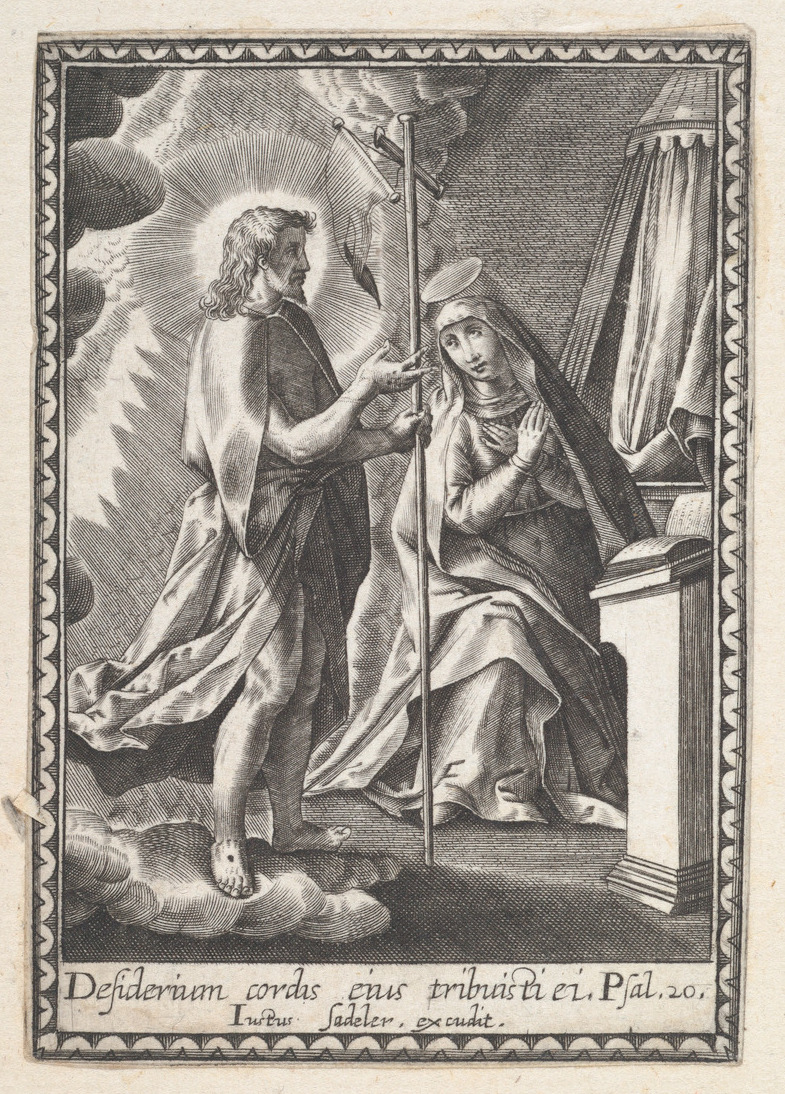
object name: print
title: Christ Appearing to His Mother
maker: Anonymous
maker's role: artist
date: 1578-1620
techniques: engraving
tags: christ,virgin mary,cross